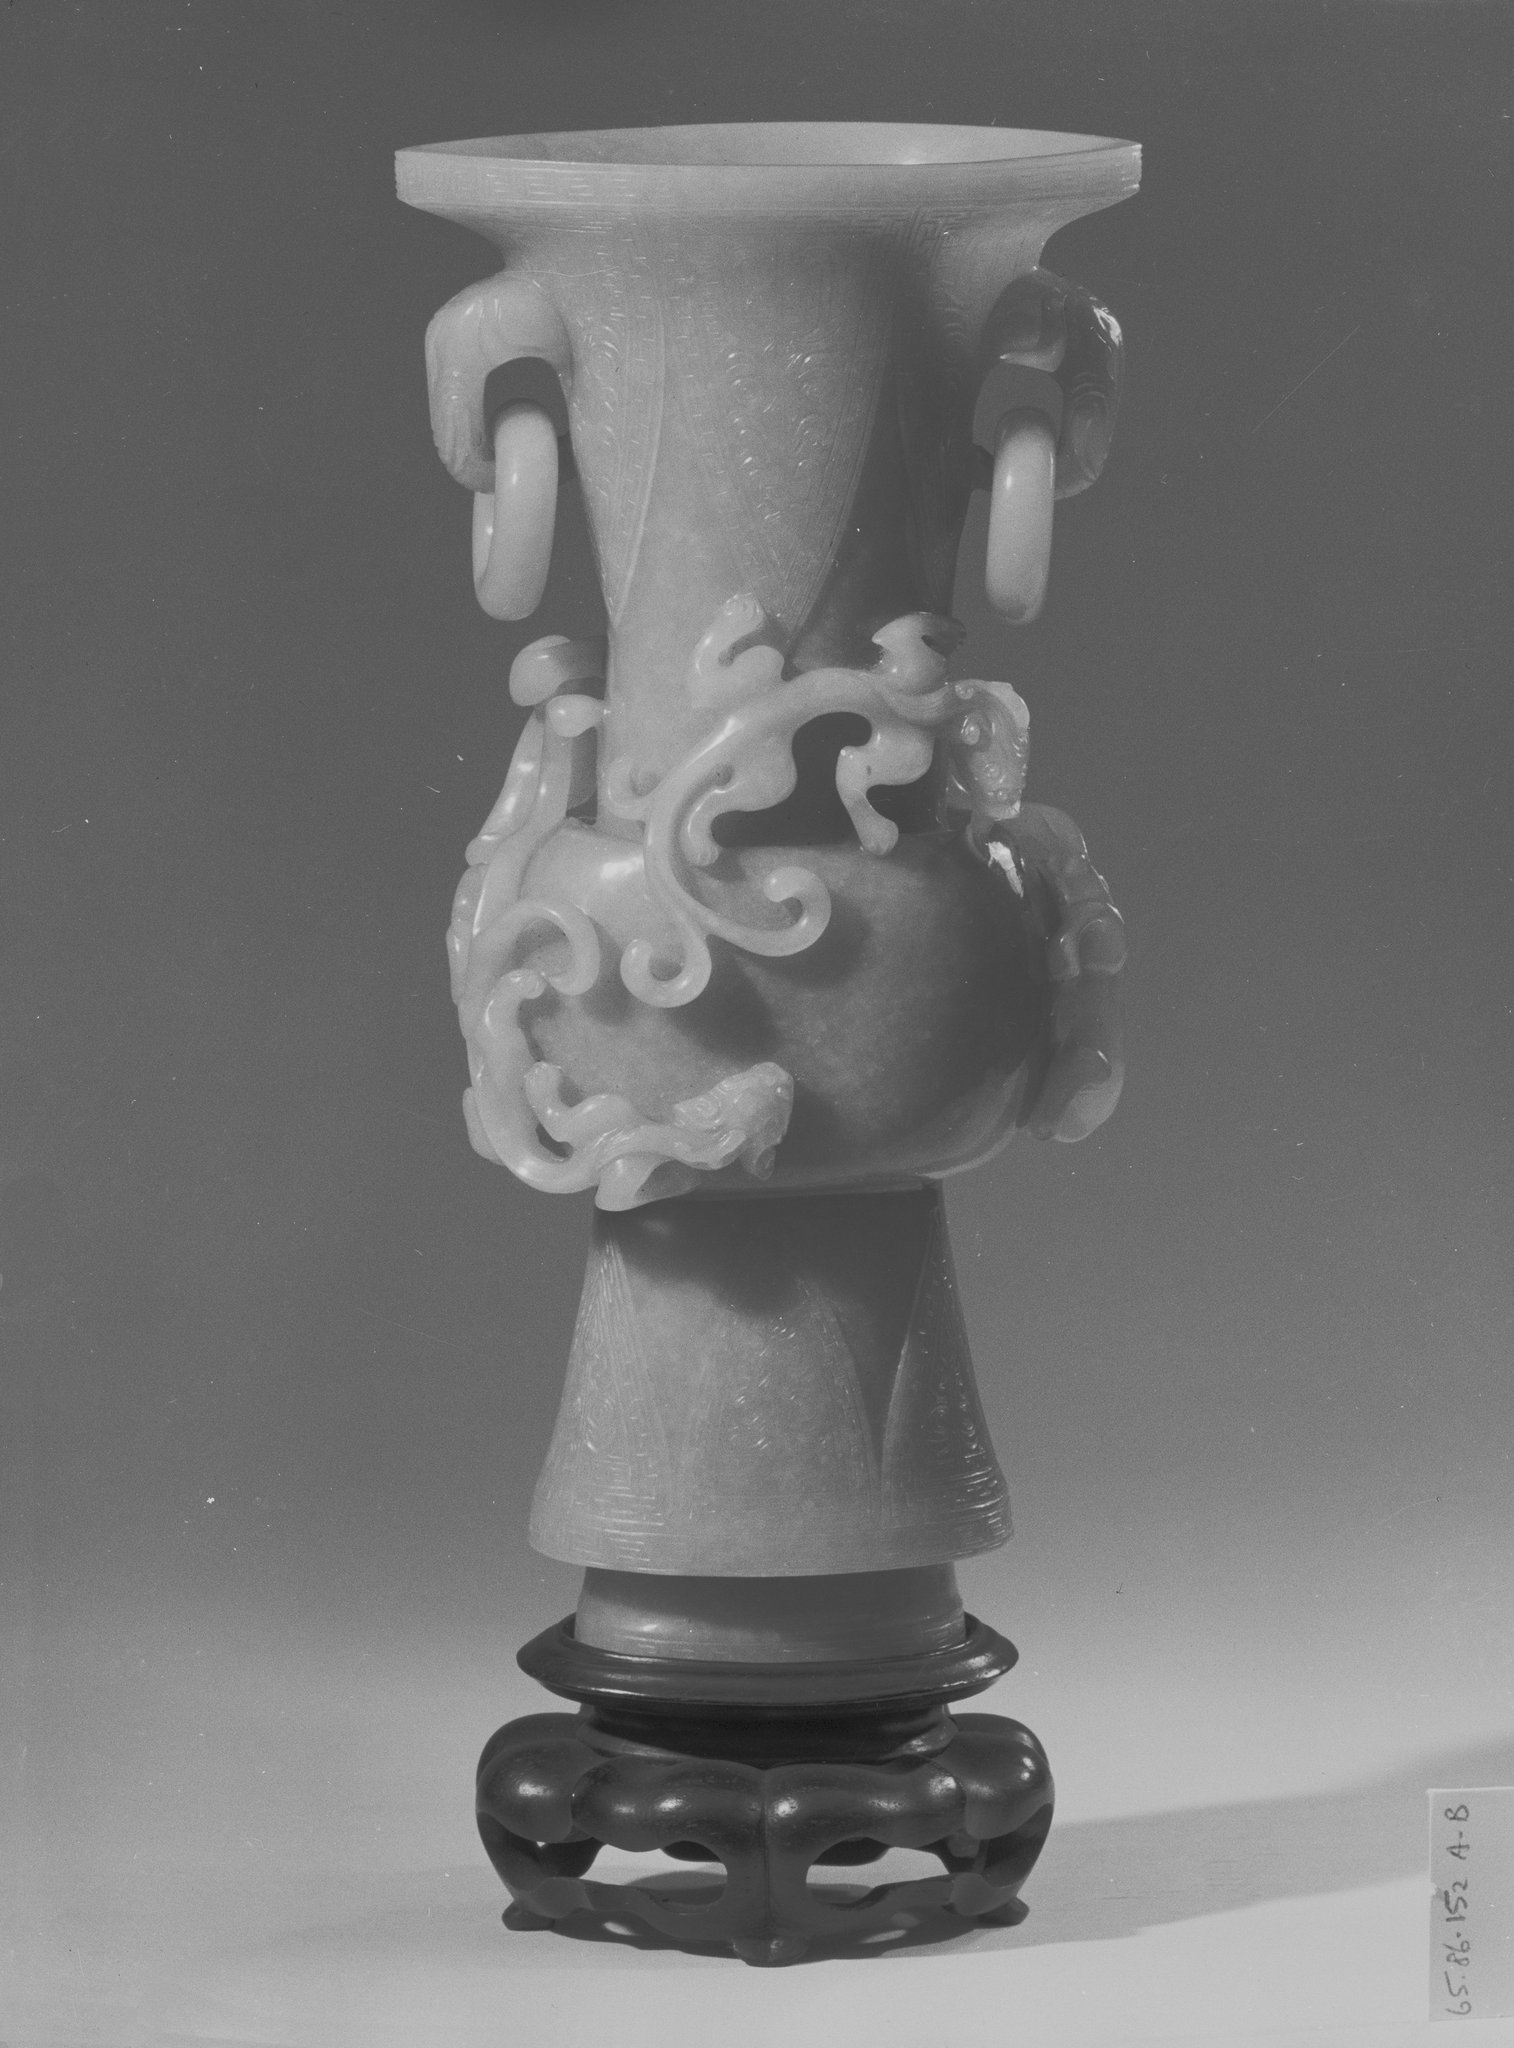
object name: beaker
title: Beaker with Ruyi Head Handles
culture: chinese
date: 1701-1800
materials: jade